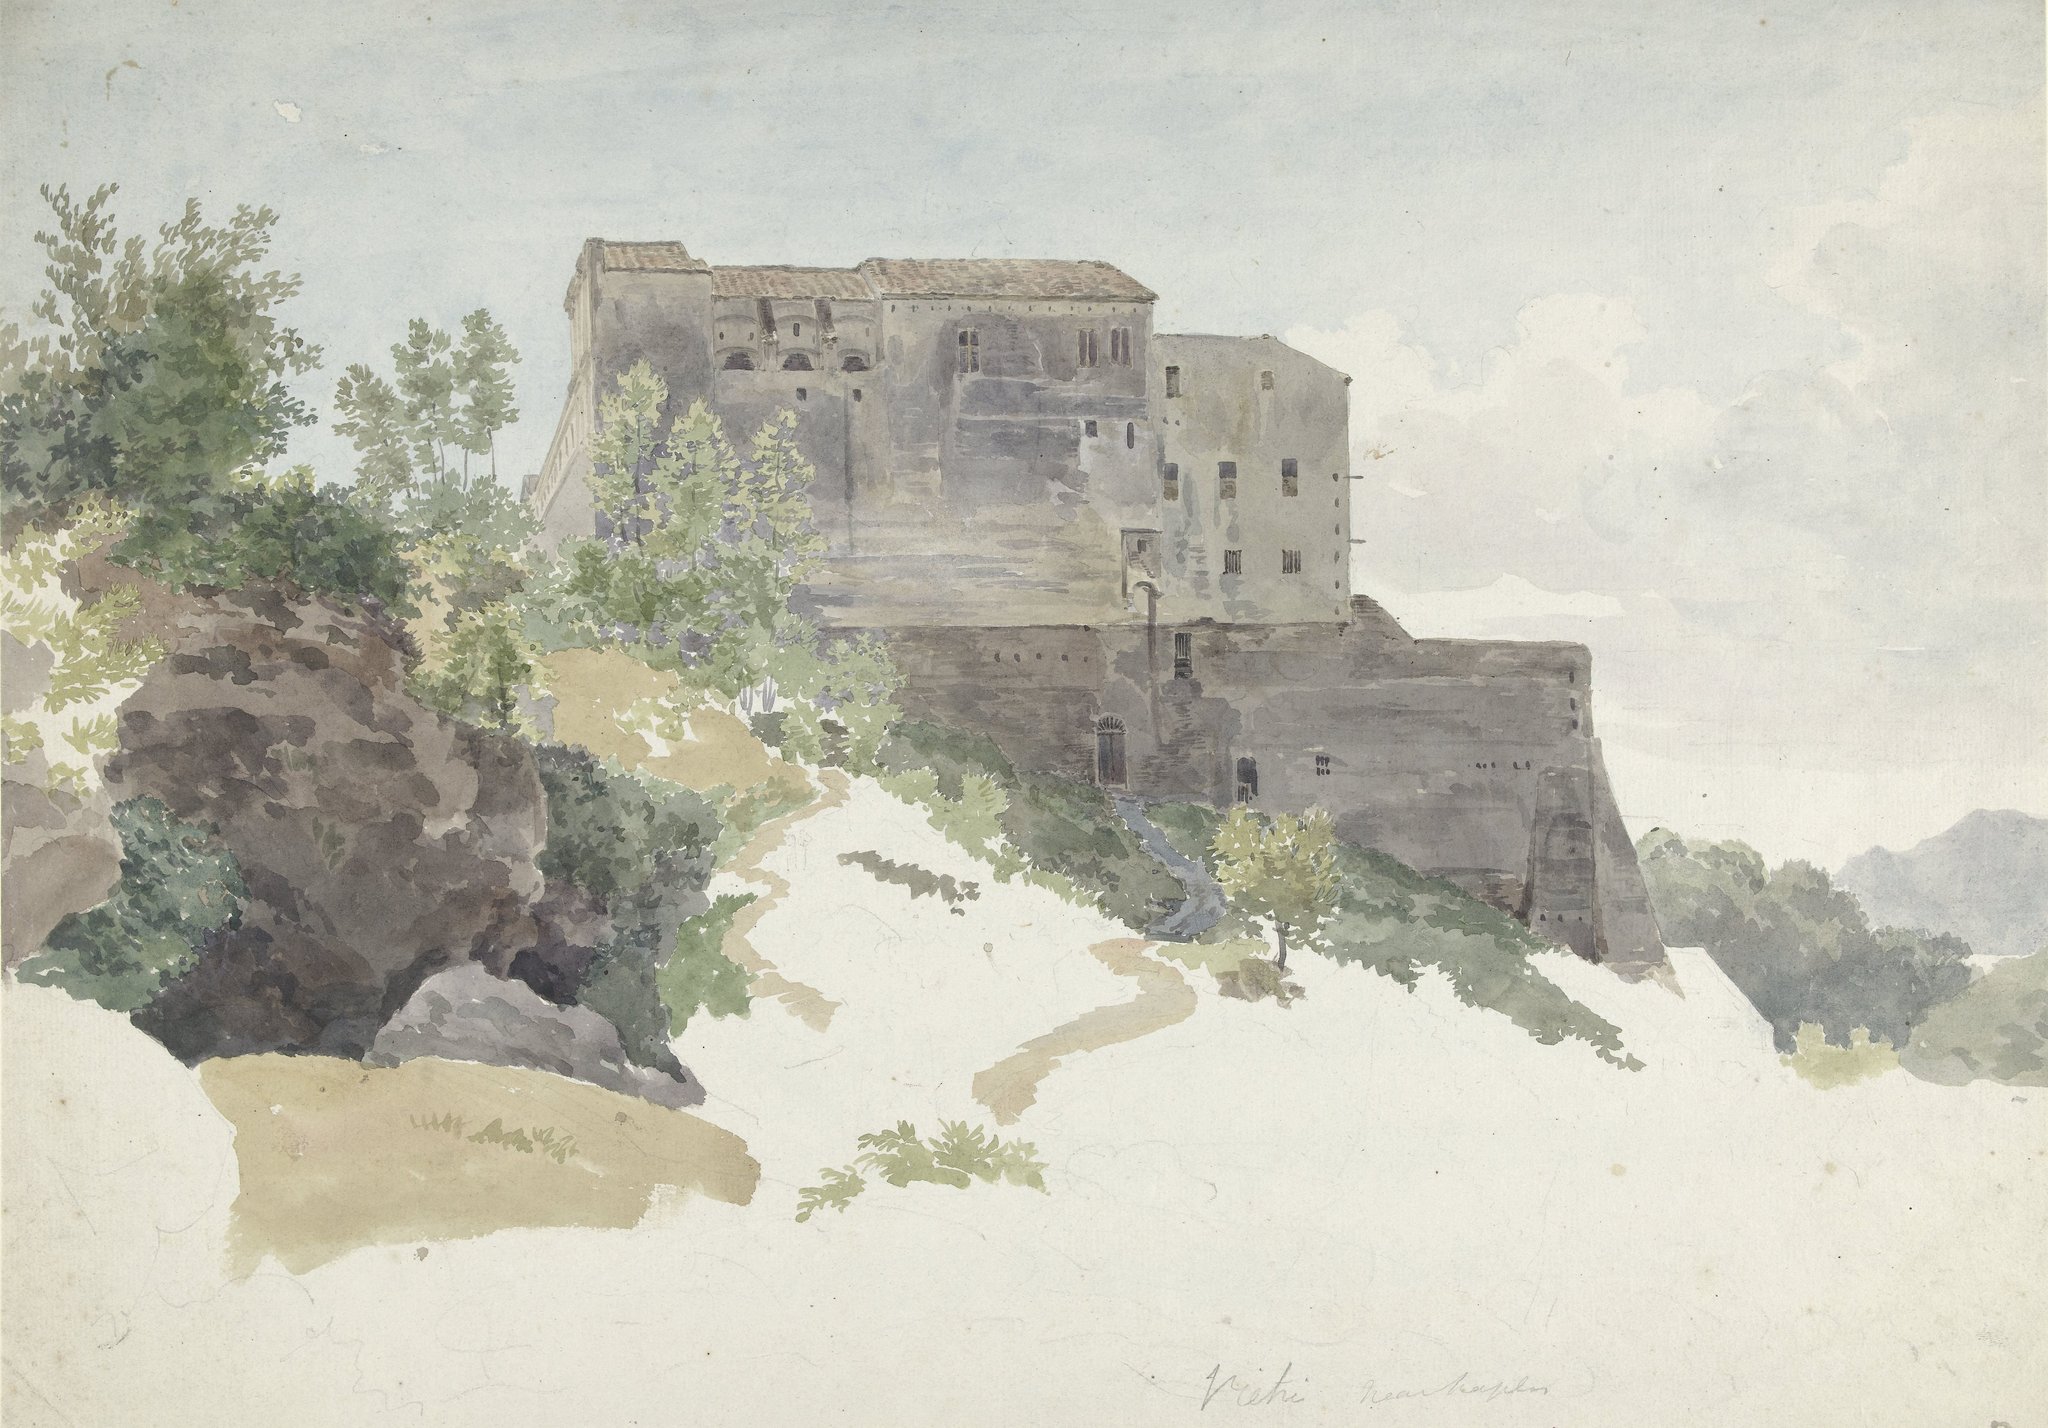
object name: drawing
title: Landschap bij Vietri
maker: henry swinburne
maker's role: draughtsman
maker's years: 1743-1803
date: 1753-1803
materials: paper, pencil, watercolor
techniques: brush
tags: landscape with tower or castle, farm or solitary house in landscape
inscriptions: : ‘Vietri near Naples’